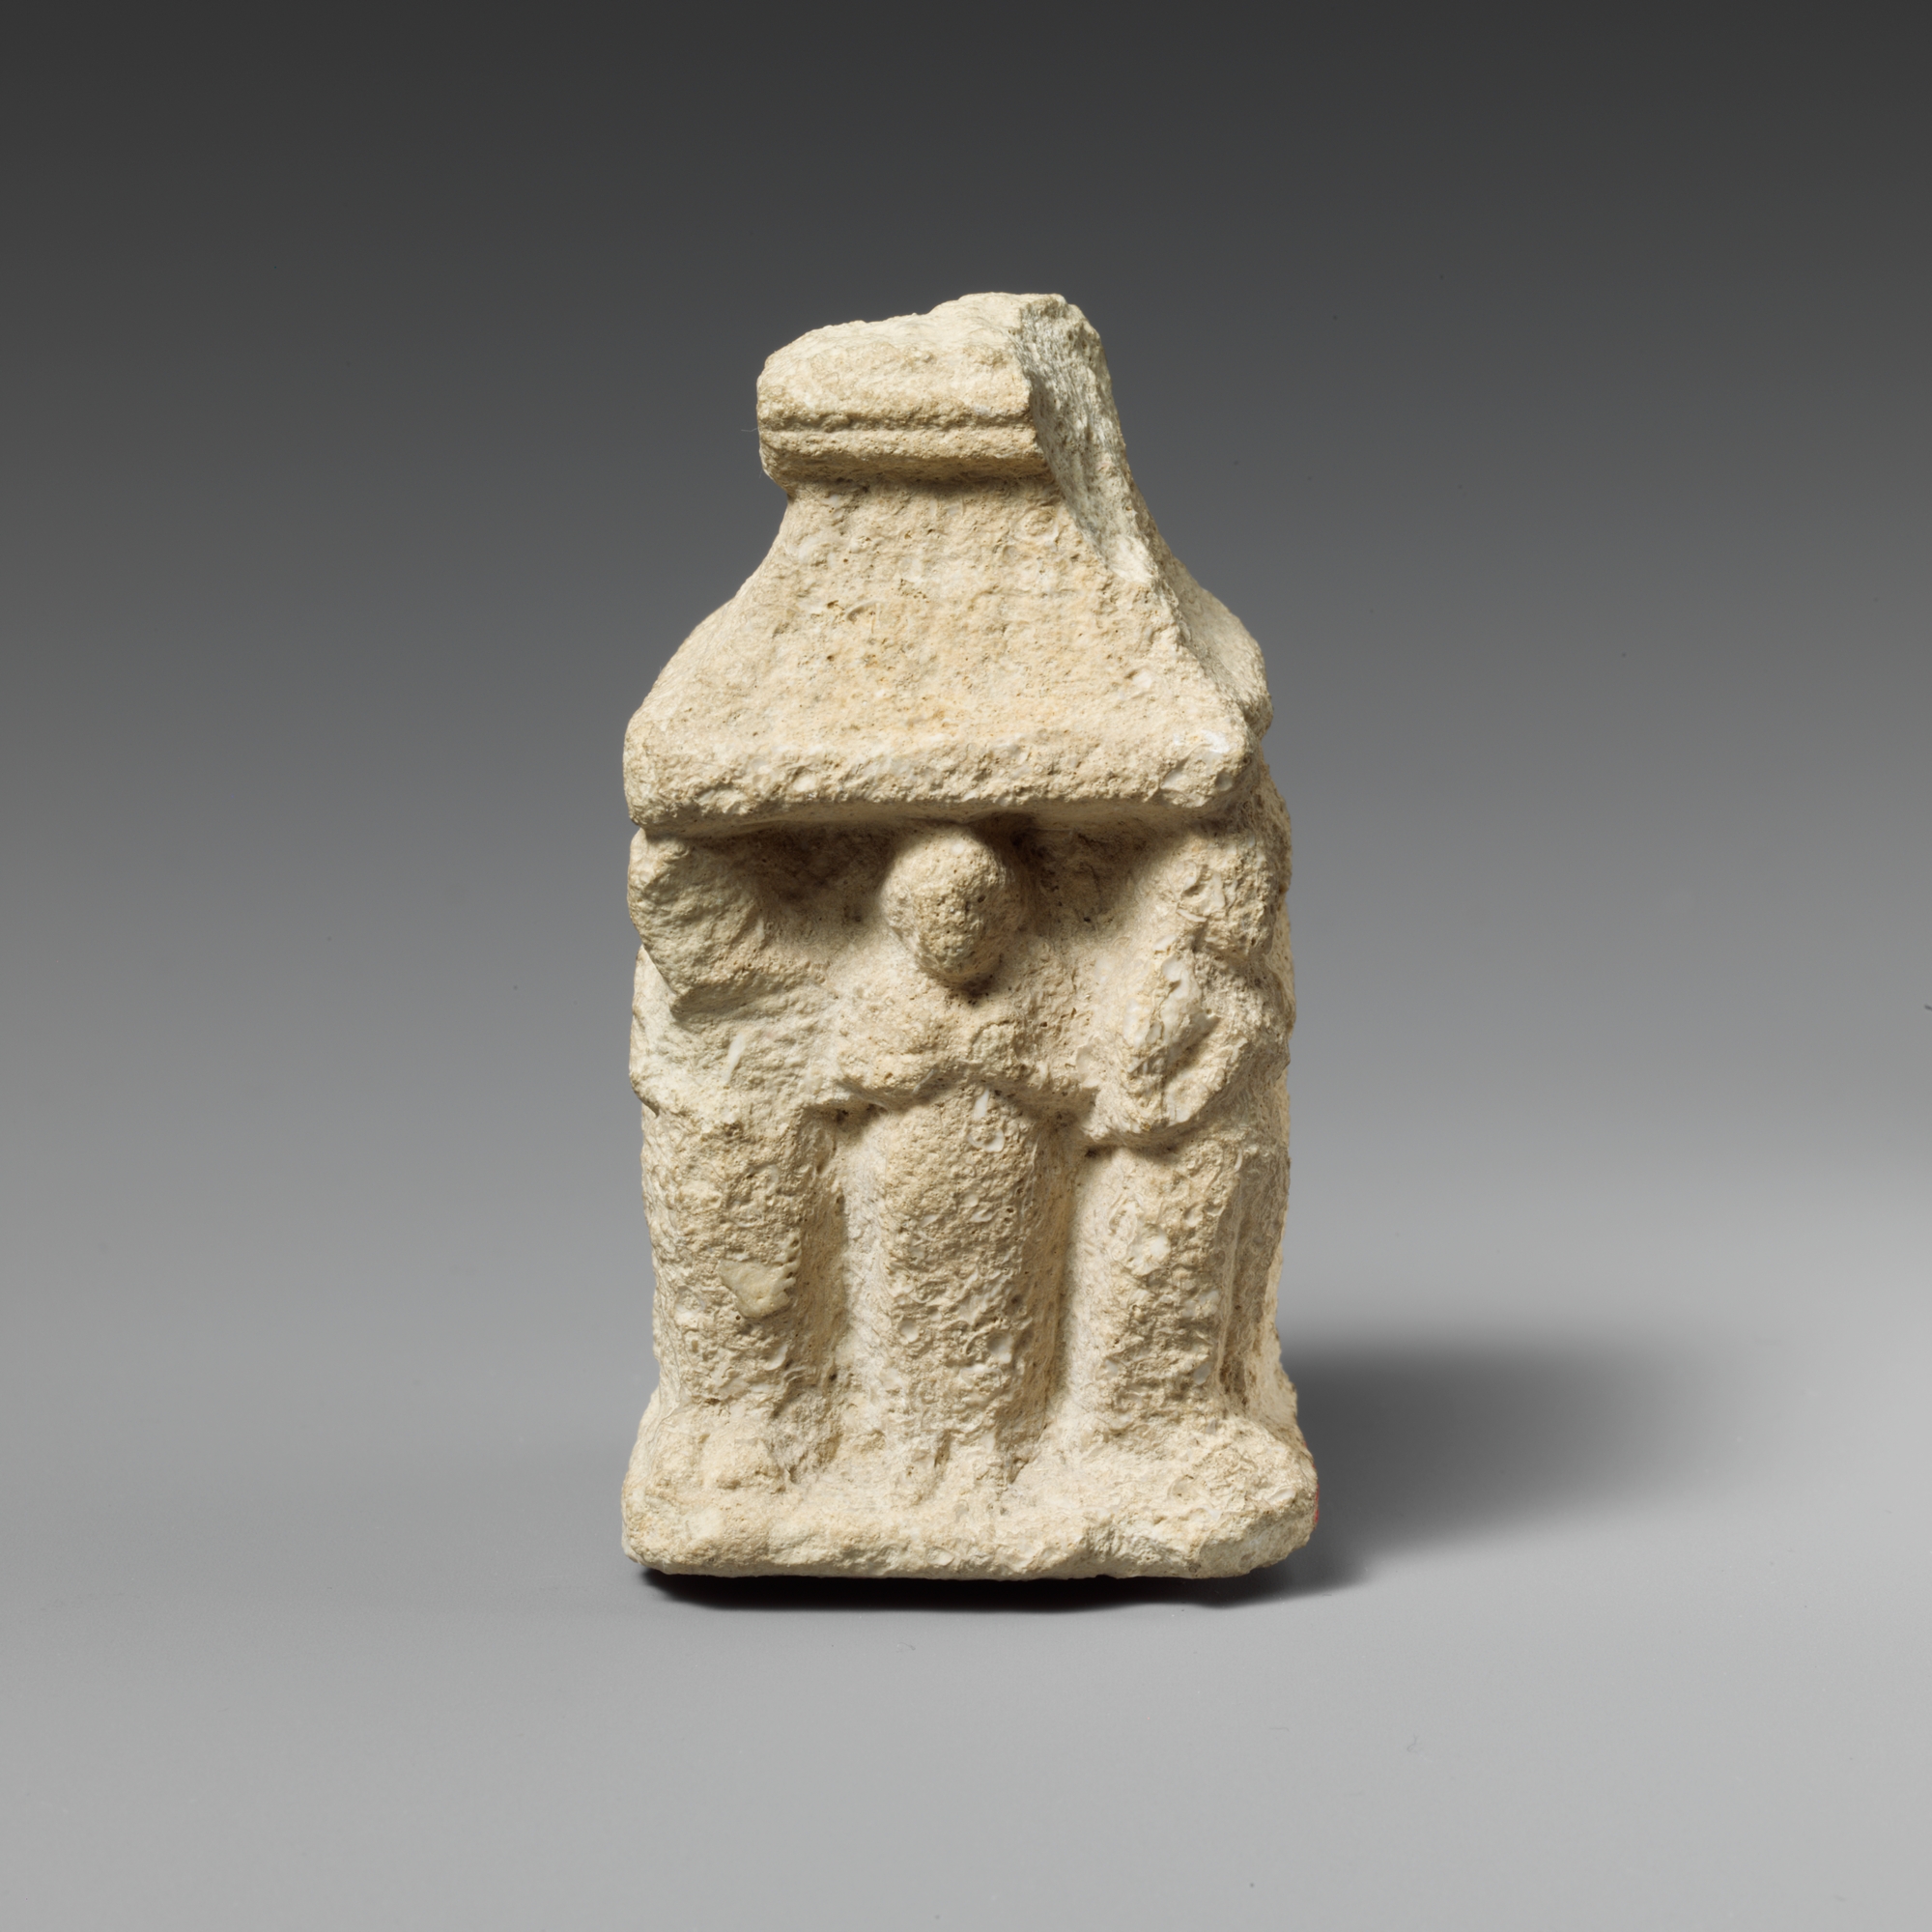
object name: altar shrine of a mother goddess, miniature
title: Limestone naiskos with female figures holding their breasts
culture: cypriot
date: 500-401 BCE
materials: limestone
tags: female nudes